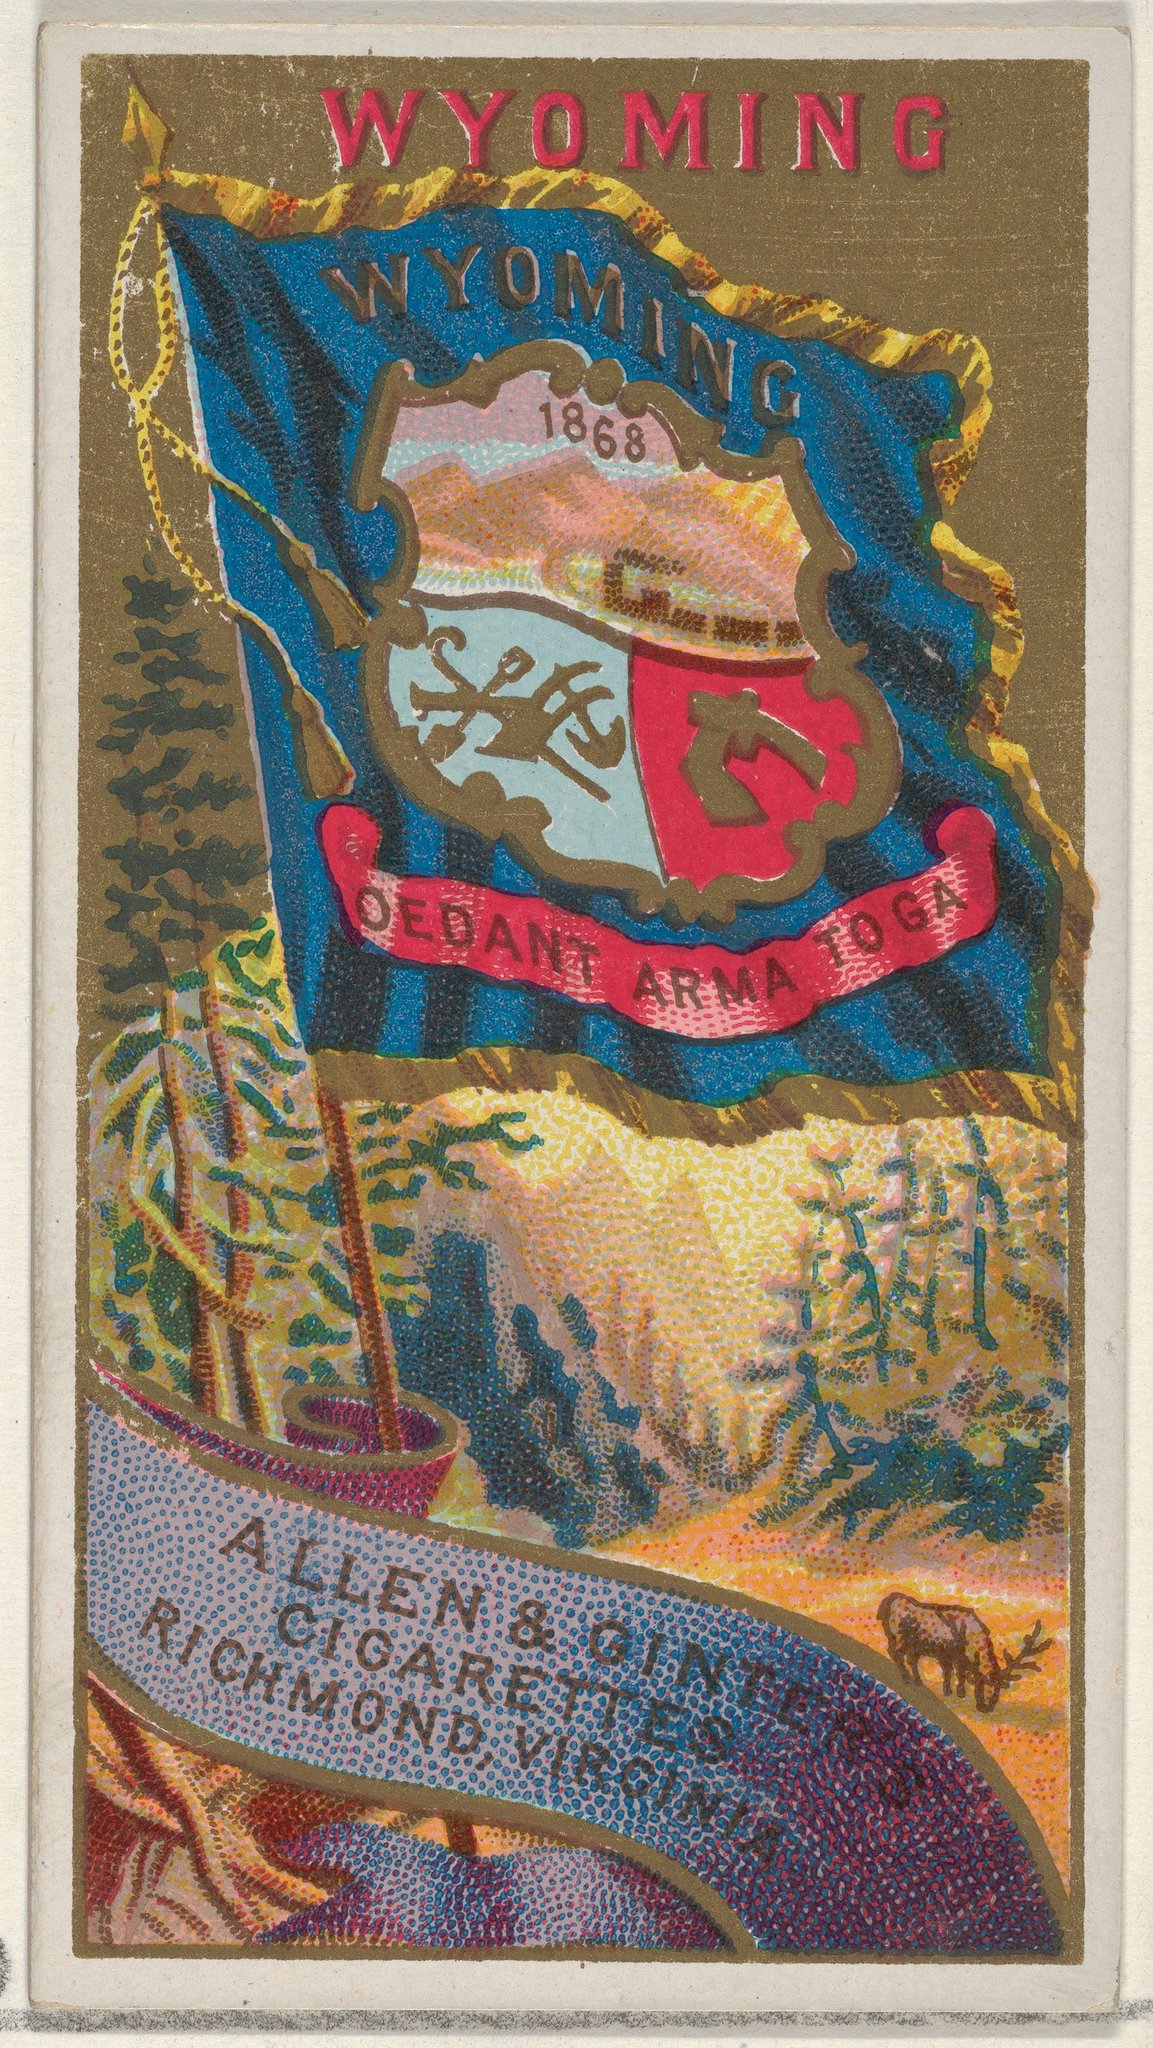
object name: print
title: Wyoming, from Flags of the States and Territories (N11) for Allen & Ginter Cigarettes Brands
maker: allen & ginter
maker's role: publisher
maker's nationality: american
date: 1888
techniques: color lithograph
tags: coat of arms,flags